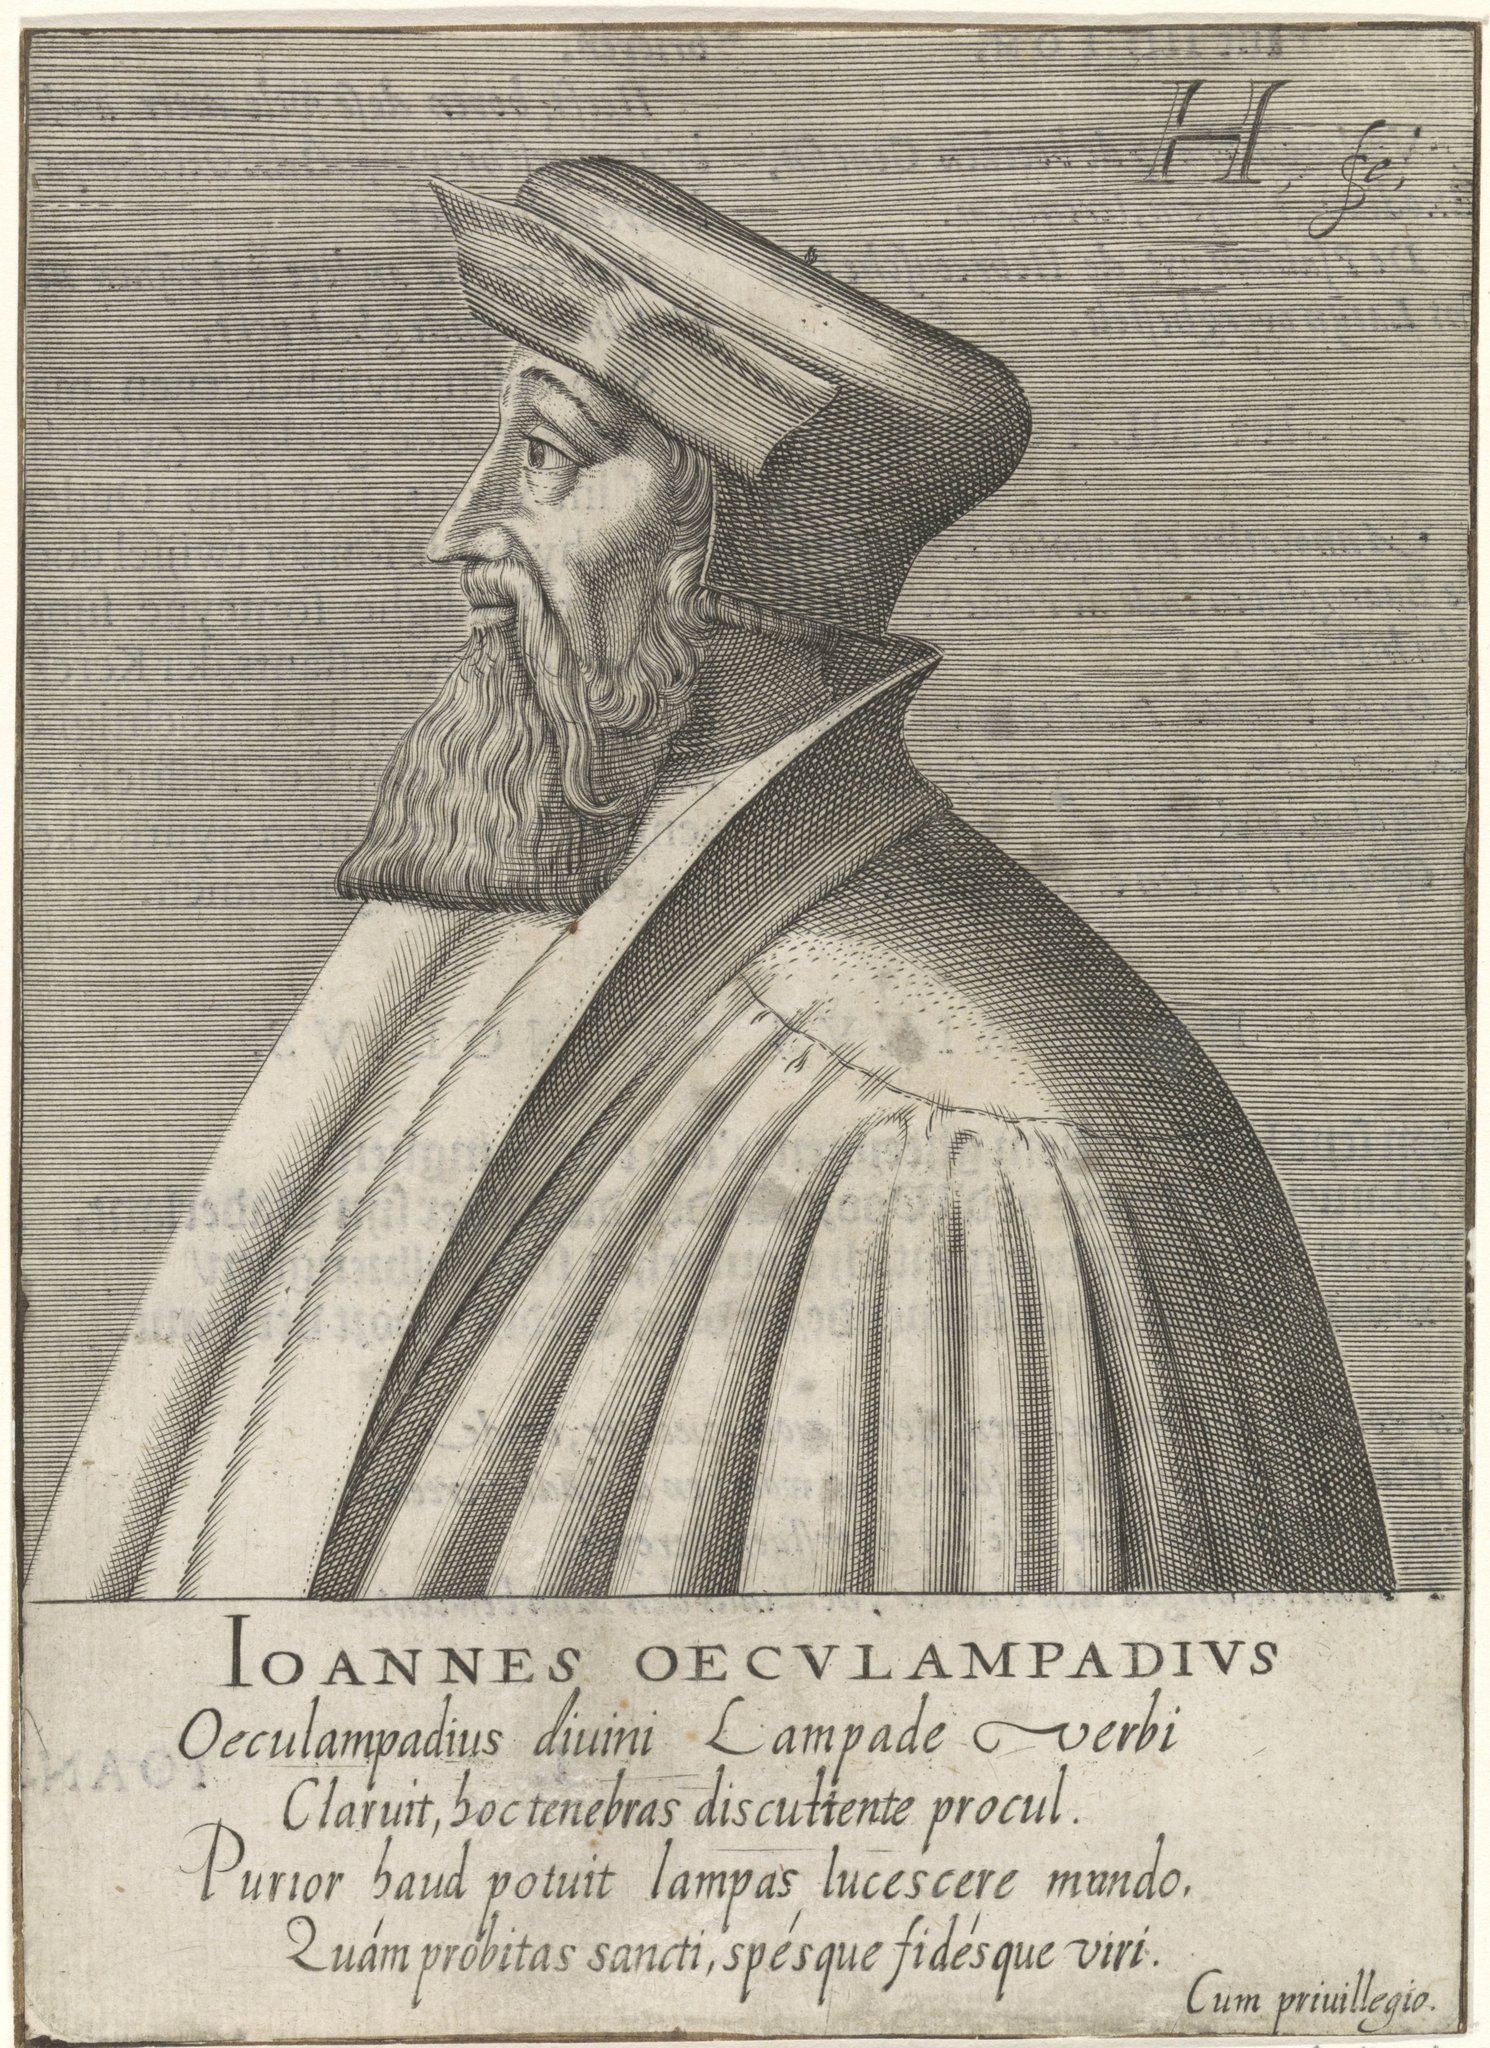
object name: print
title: Beroemde hervormers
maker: hendrick hondius (i)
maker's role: draughtsman, print maker, publisher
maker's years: 1573-1650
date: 1599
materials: paper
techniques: engraving, letterpress printing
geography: the hague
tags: weinsberg, bazel, theoloog, johannes oecolampadius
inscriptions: collector's mark: Lugt 2228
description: Prent ook gebruikt als boekillustratie in: Jacob Verheiden, Præstantium aliquot theologorum, qui rom. antichristum præcipuè oppugnarunt, effigies. Den Haag: Hendrick Hondius I en Den Haag: B.C. Nieulandt, 1602-1603. Tevens: Arnhem, J.Janssen, 1604.